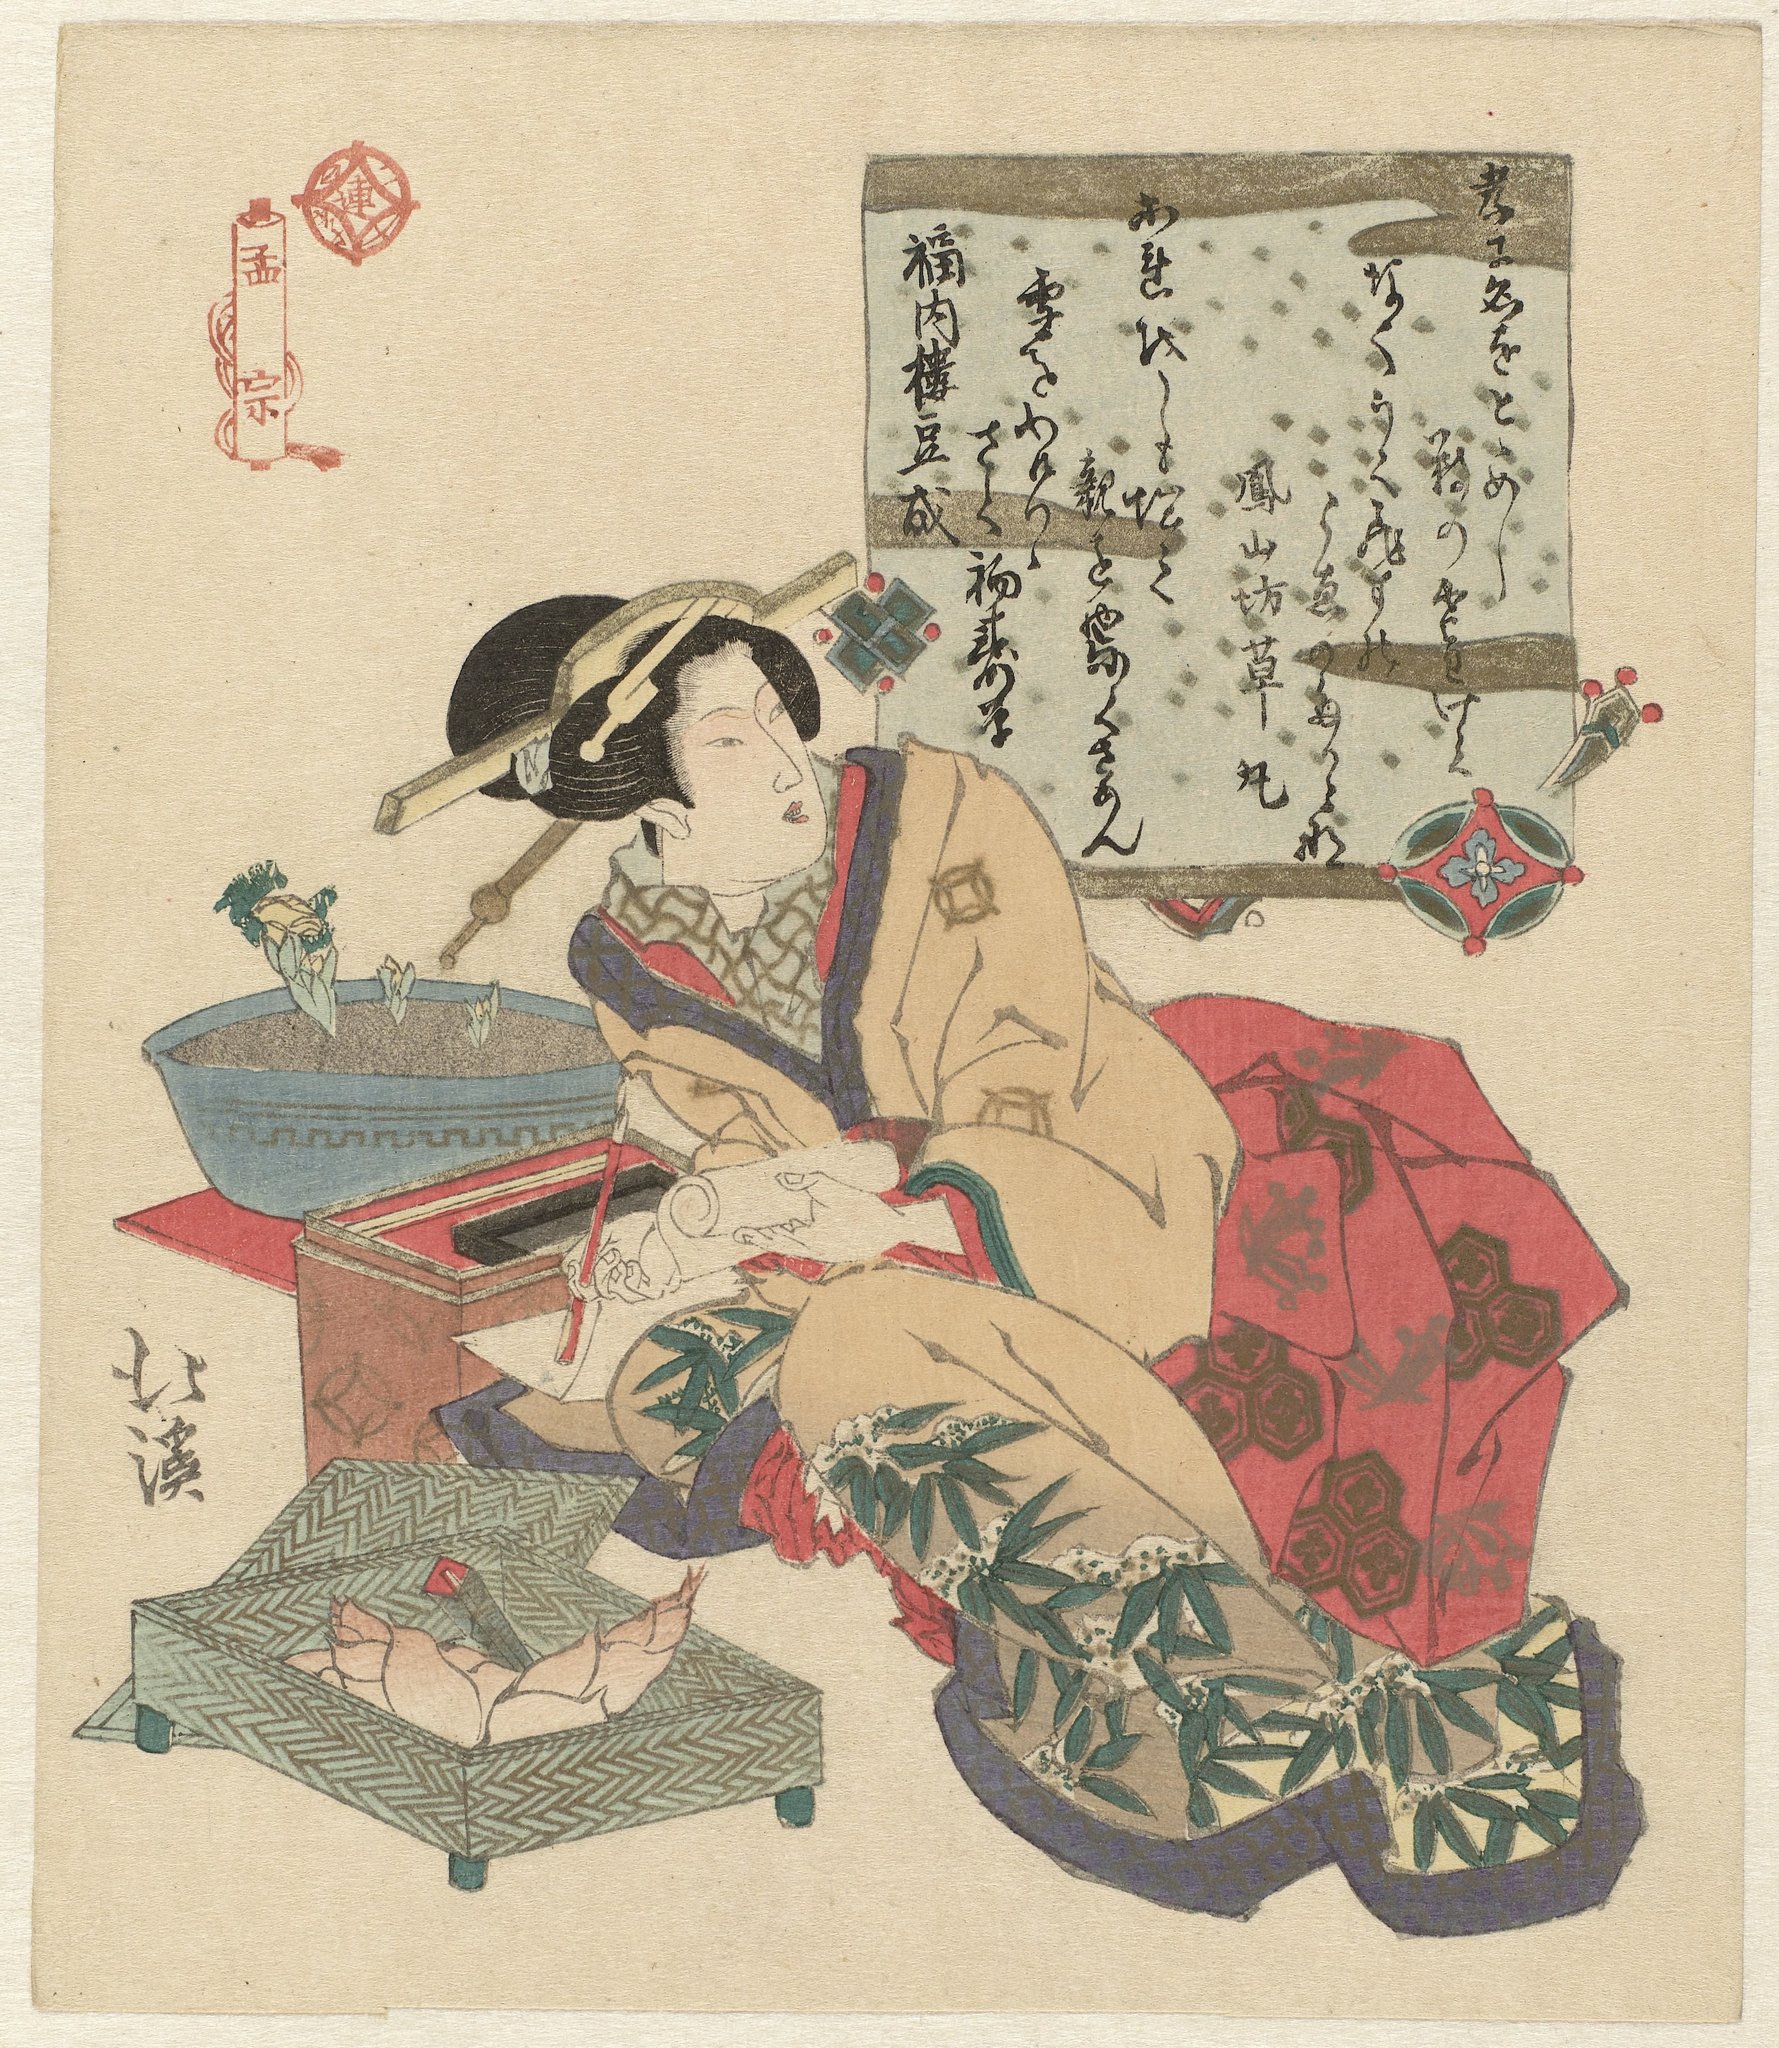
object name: surimono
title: Môsô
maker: totoya hokkei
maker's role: print maker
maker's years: 1790-1850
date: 1890-1900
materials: paper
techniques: woodcut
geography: japan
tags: writing accessories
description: Een surimono is een luxe uitgevoerde prent waarop beeld met één of meerdere gedichten gecombineerd is. Bij het drukken van een surimono werd vaak gebruik gemaakt van dikker papier, blinddruk en metaal pigmenten, zoals koper- en zilverpoeder. De prenten werden vaak in opdracht van dichters gemaakt en als exclusief geschenk aan vrienden en relaties gegeven.